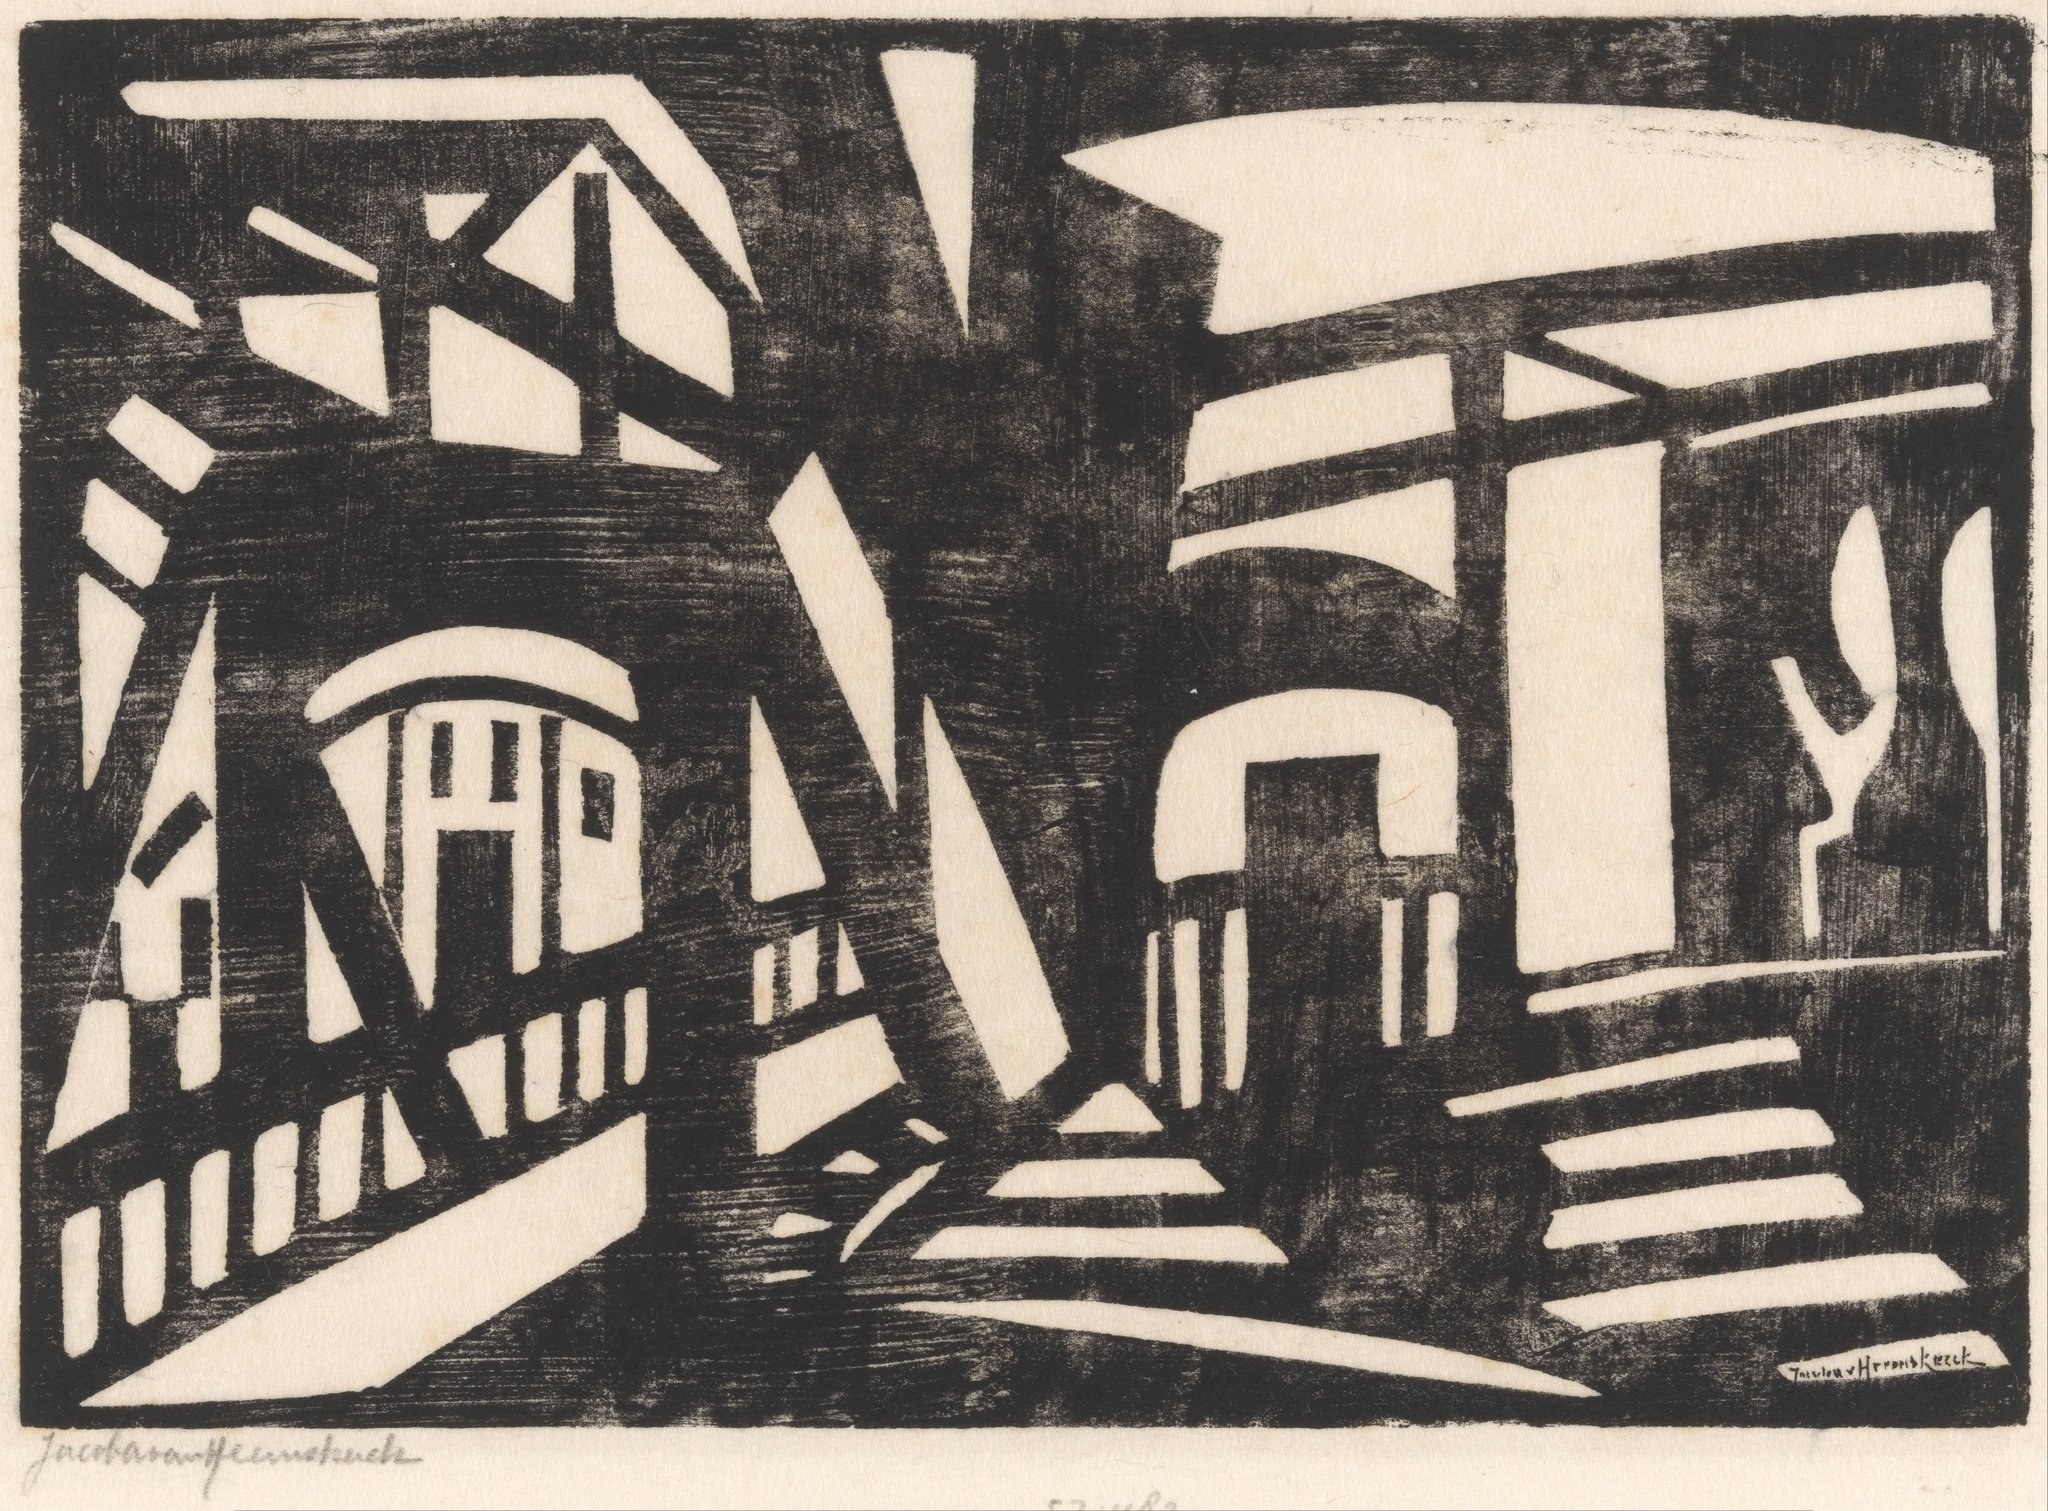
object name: print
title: Compositie no. 15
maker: jacoba van heemskerck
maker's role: draughtsman, painter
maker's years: 1876-1923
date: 1915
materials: paper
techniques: woodcut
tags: bridge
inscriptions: collector's mark: Lugt 2228